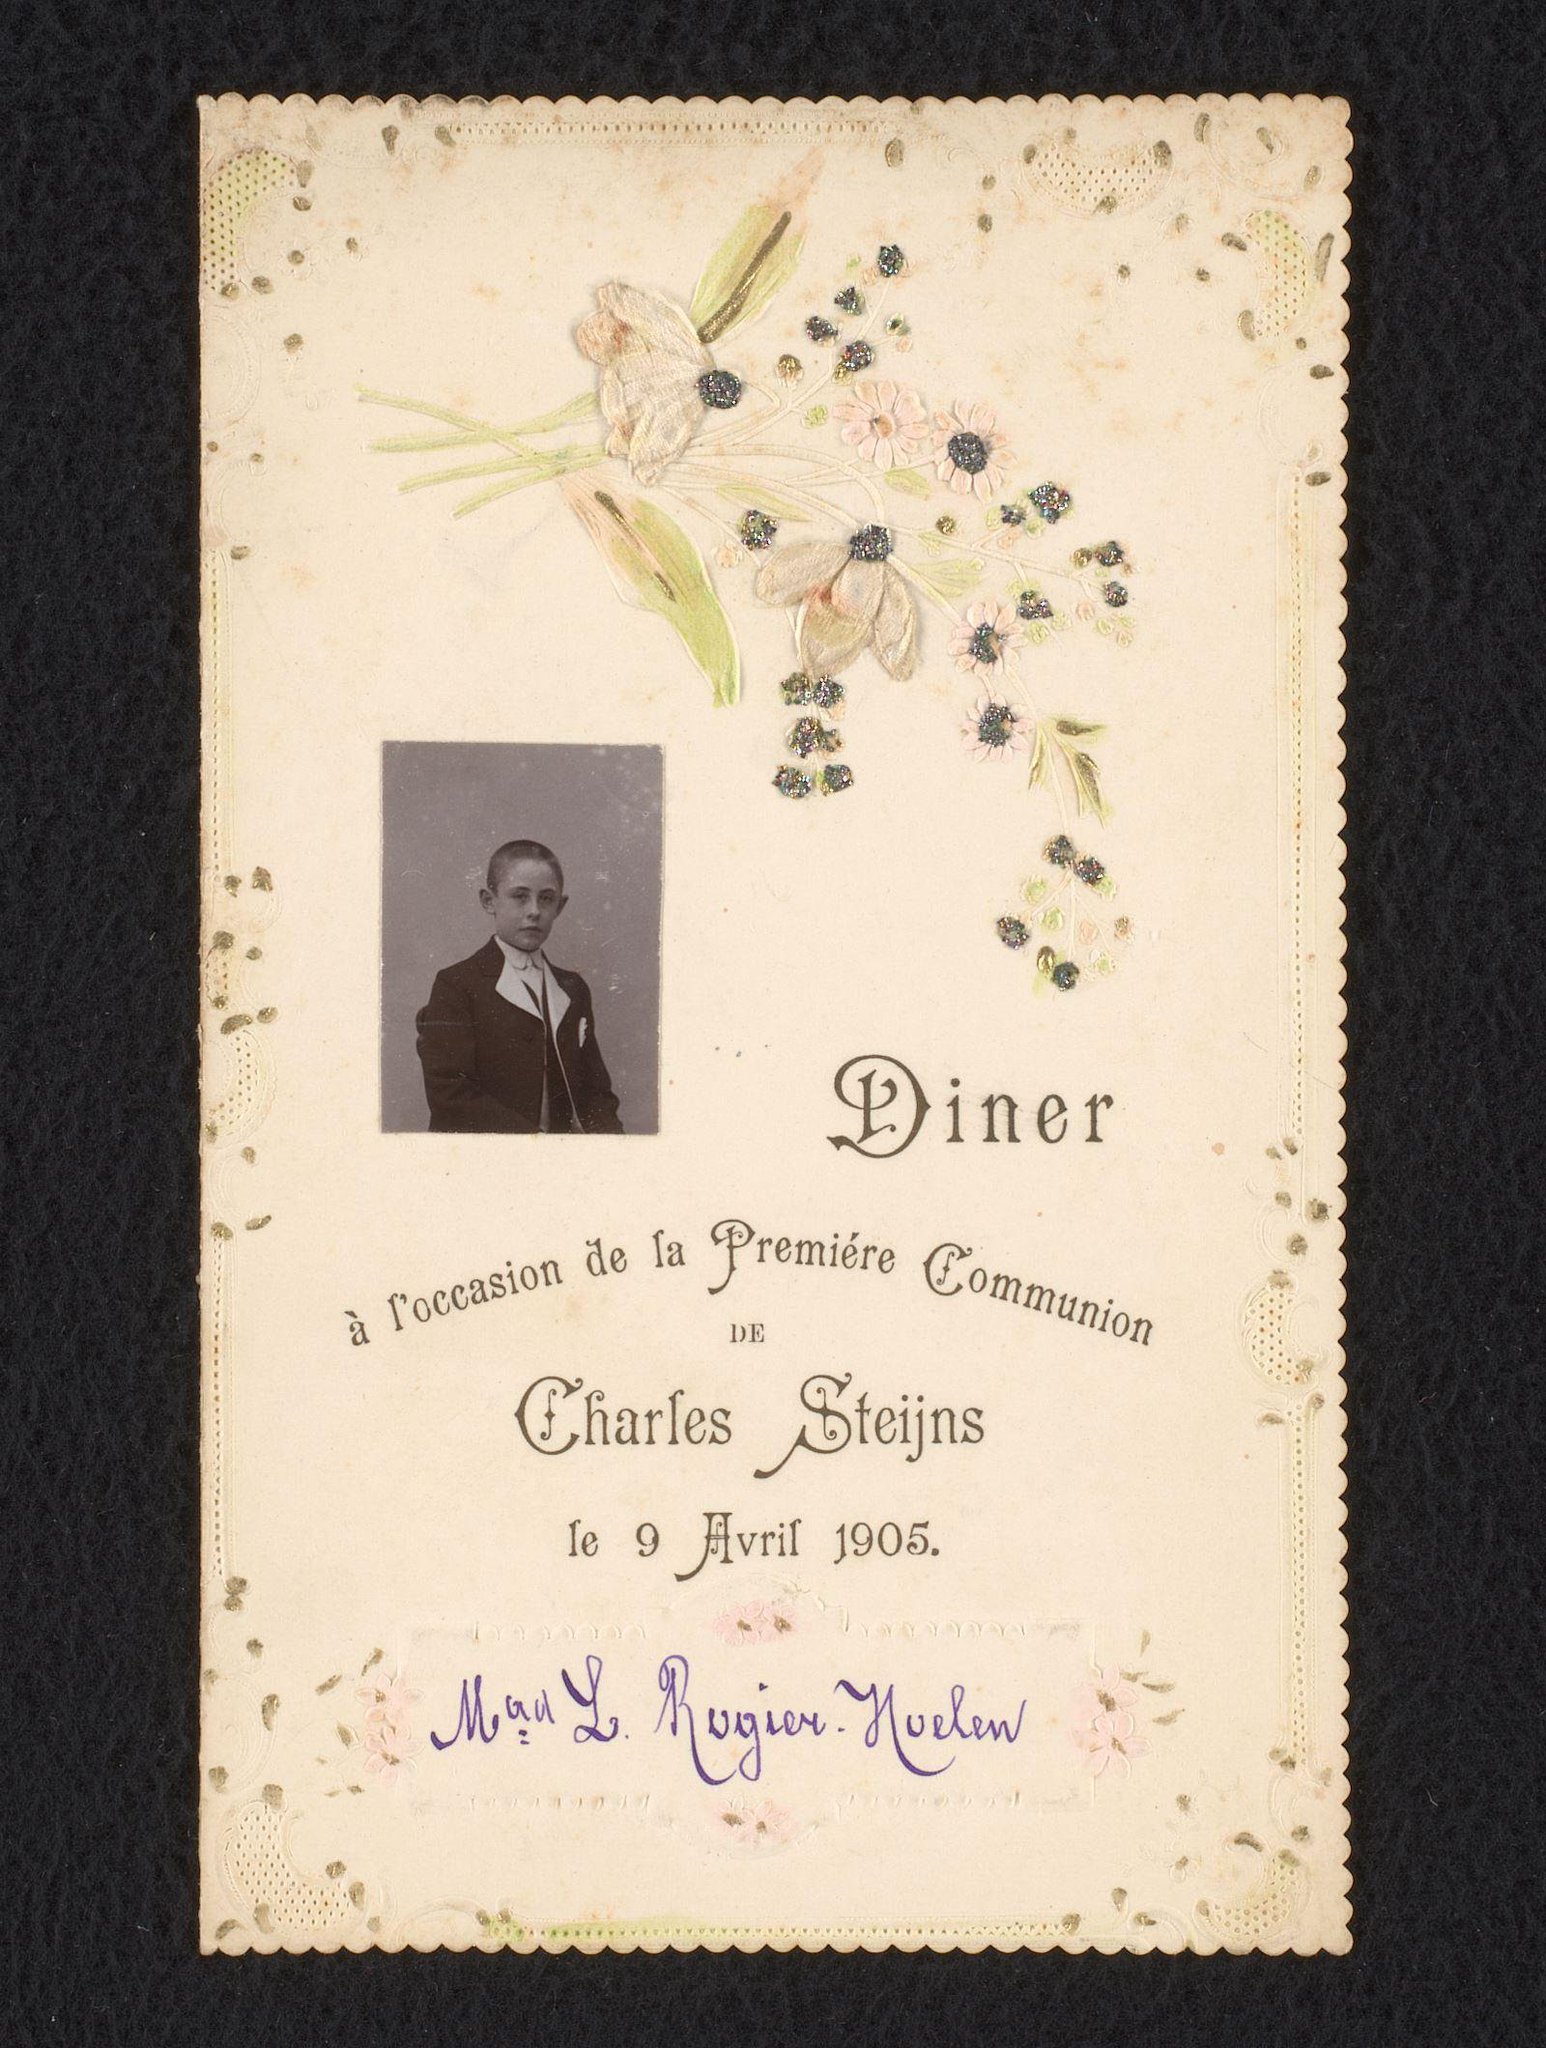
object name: menu, menukaart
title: Menukaart voor het diner bij de eerste heilige communie van Charles Steyns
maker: Anonymous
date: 1905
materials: paper, glitter, silk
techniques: blind stamped, lithograph, letterpress printing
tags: first communion, historical persons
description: Op de voorzijde: de tekst van de uitnodiging voor het diner op 9 april 1905, met een portret van Charles Steyns. In een lege ruimte is de naam van de genodigde geschreven ('Mad. L. Rogier-Huelen'). Binnenin het menu en de drankkaart voor het diner.